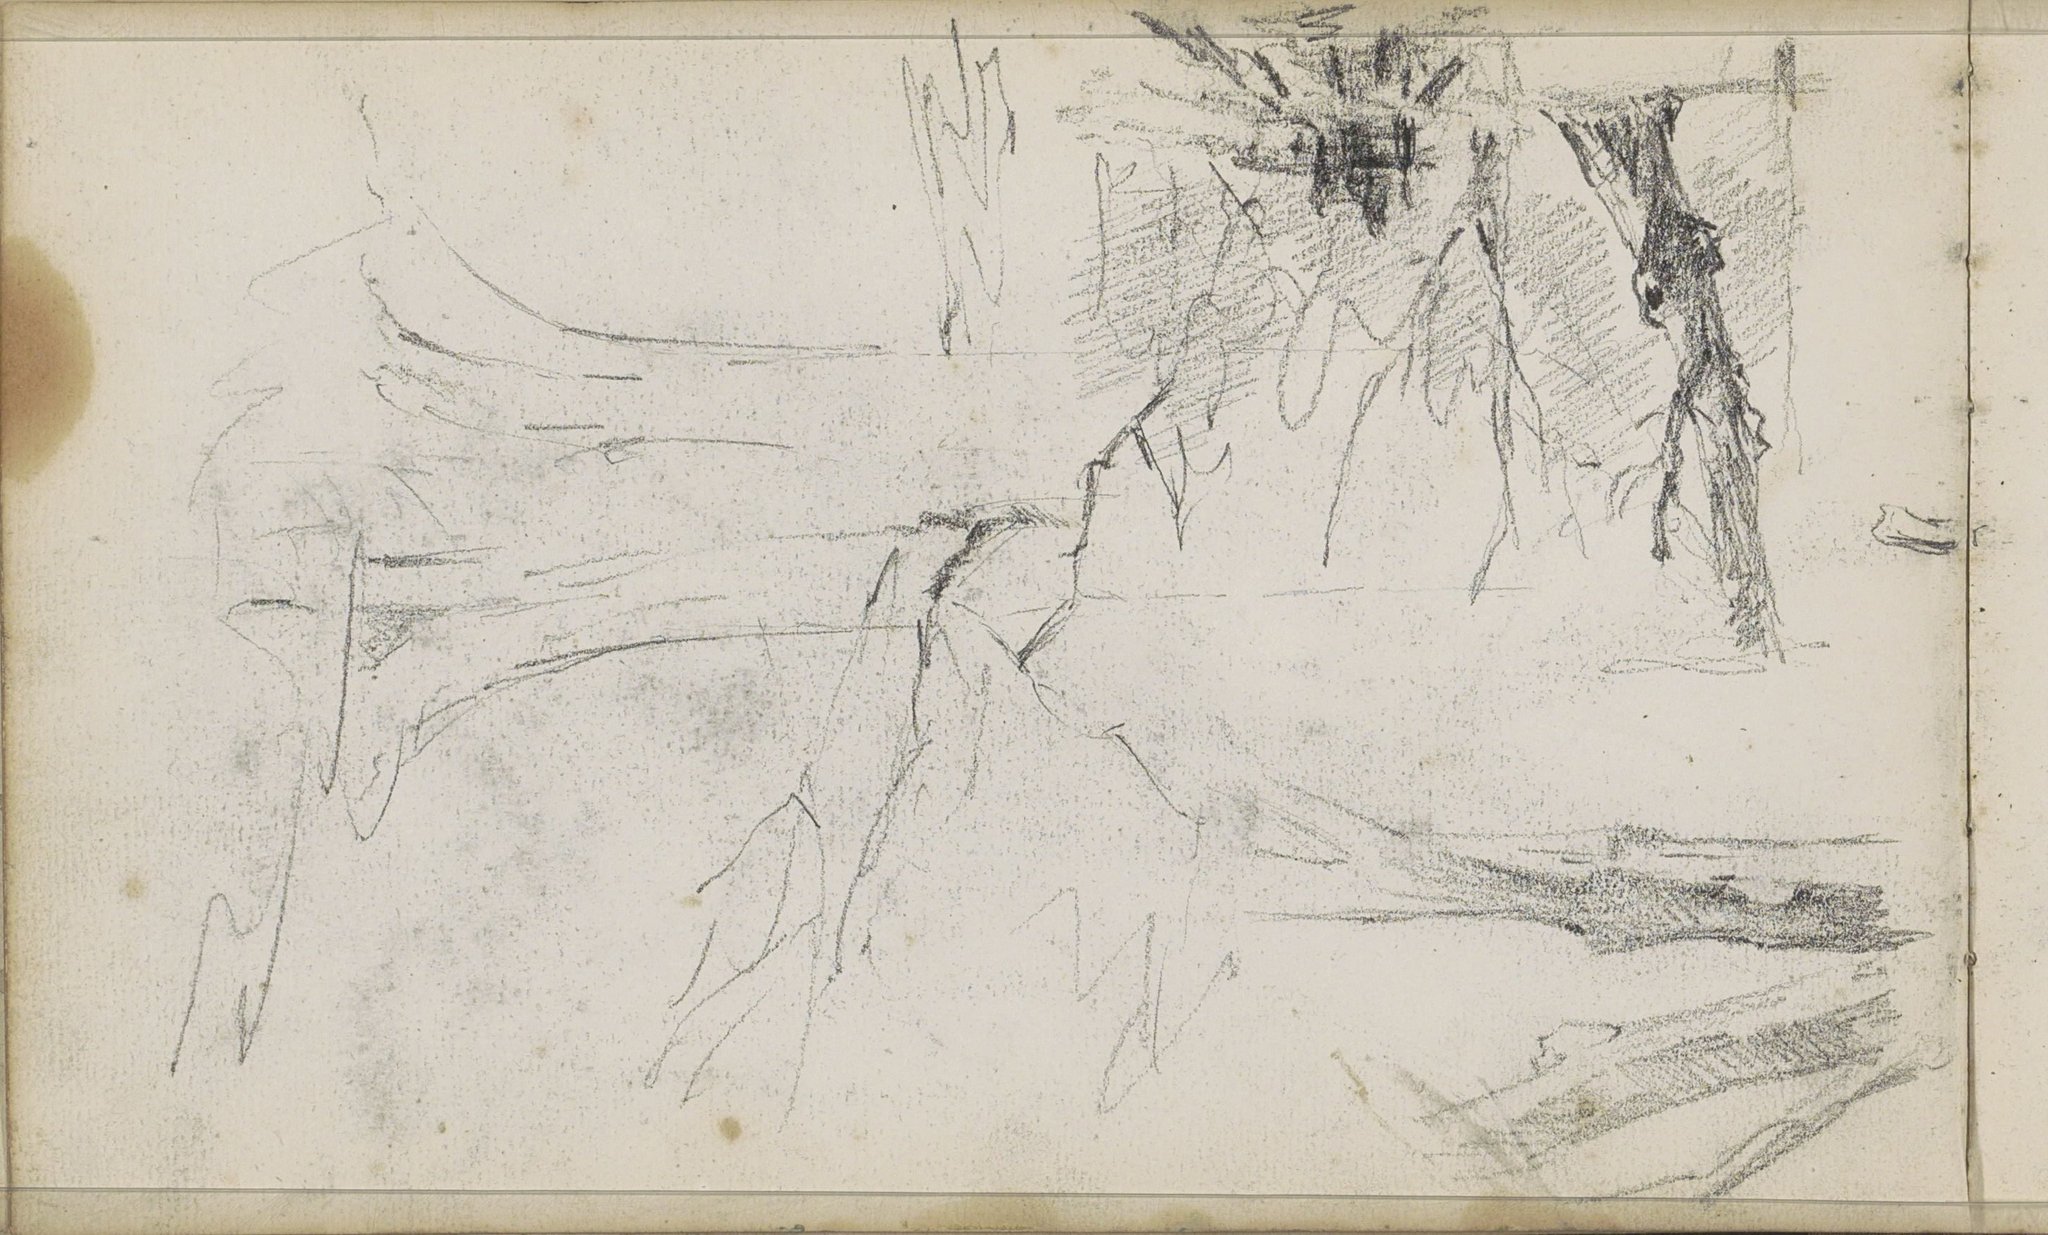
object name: sketchbook leaf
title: Kar op een landweg, een boomstam en takken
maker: willem cornelis rip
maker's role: draughtsman, painter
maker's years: 1856-1922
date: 1876-1877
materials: paper, pencil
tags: animal traction, animal-drawn vehicle (carriage etc.), trees (+ stem, trunk), road, path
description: Blad 17 verso uit een schetsboek met 41 bladen.